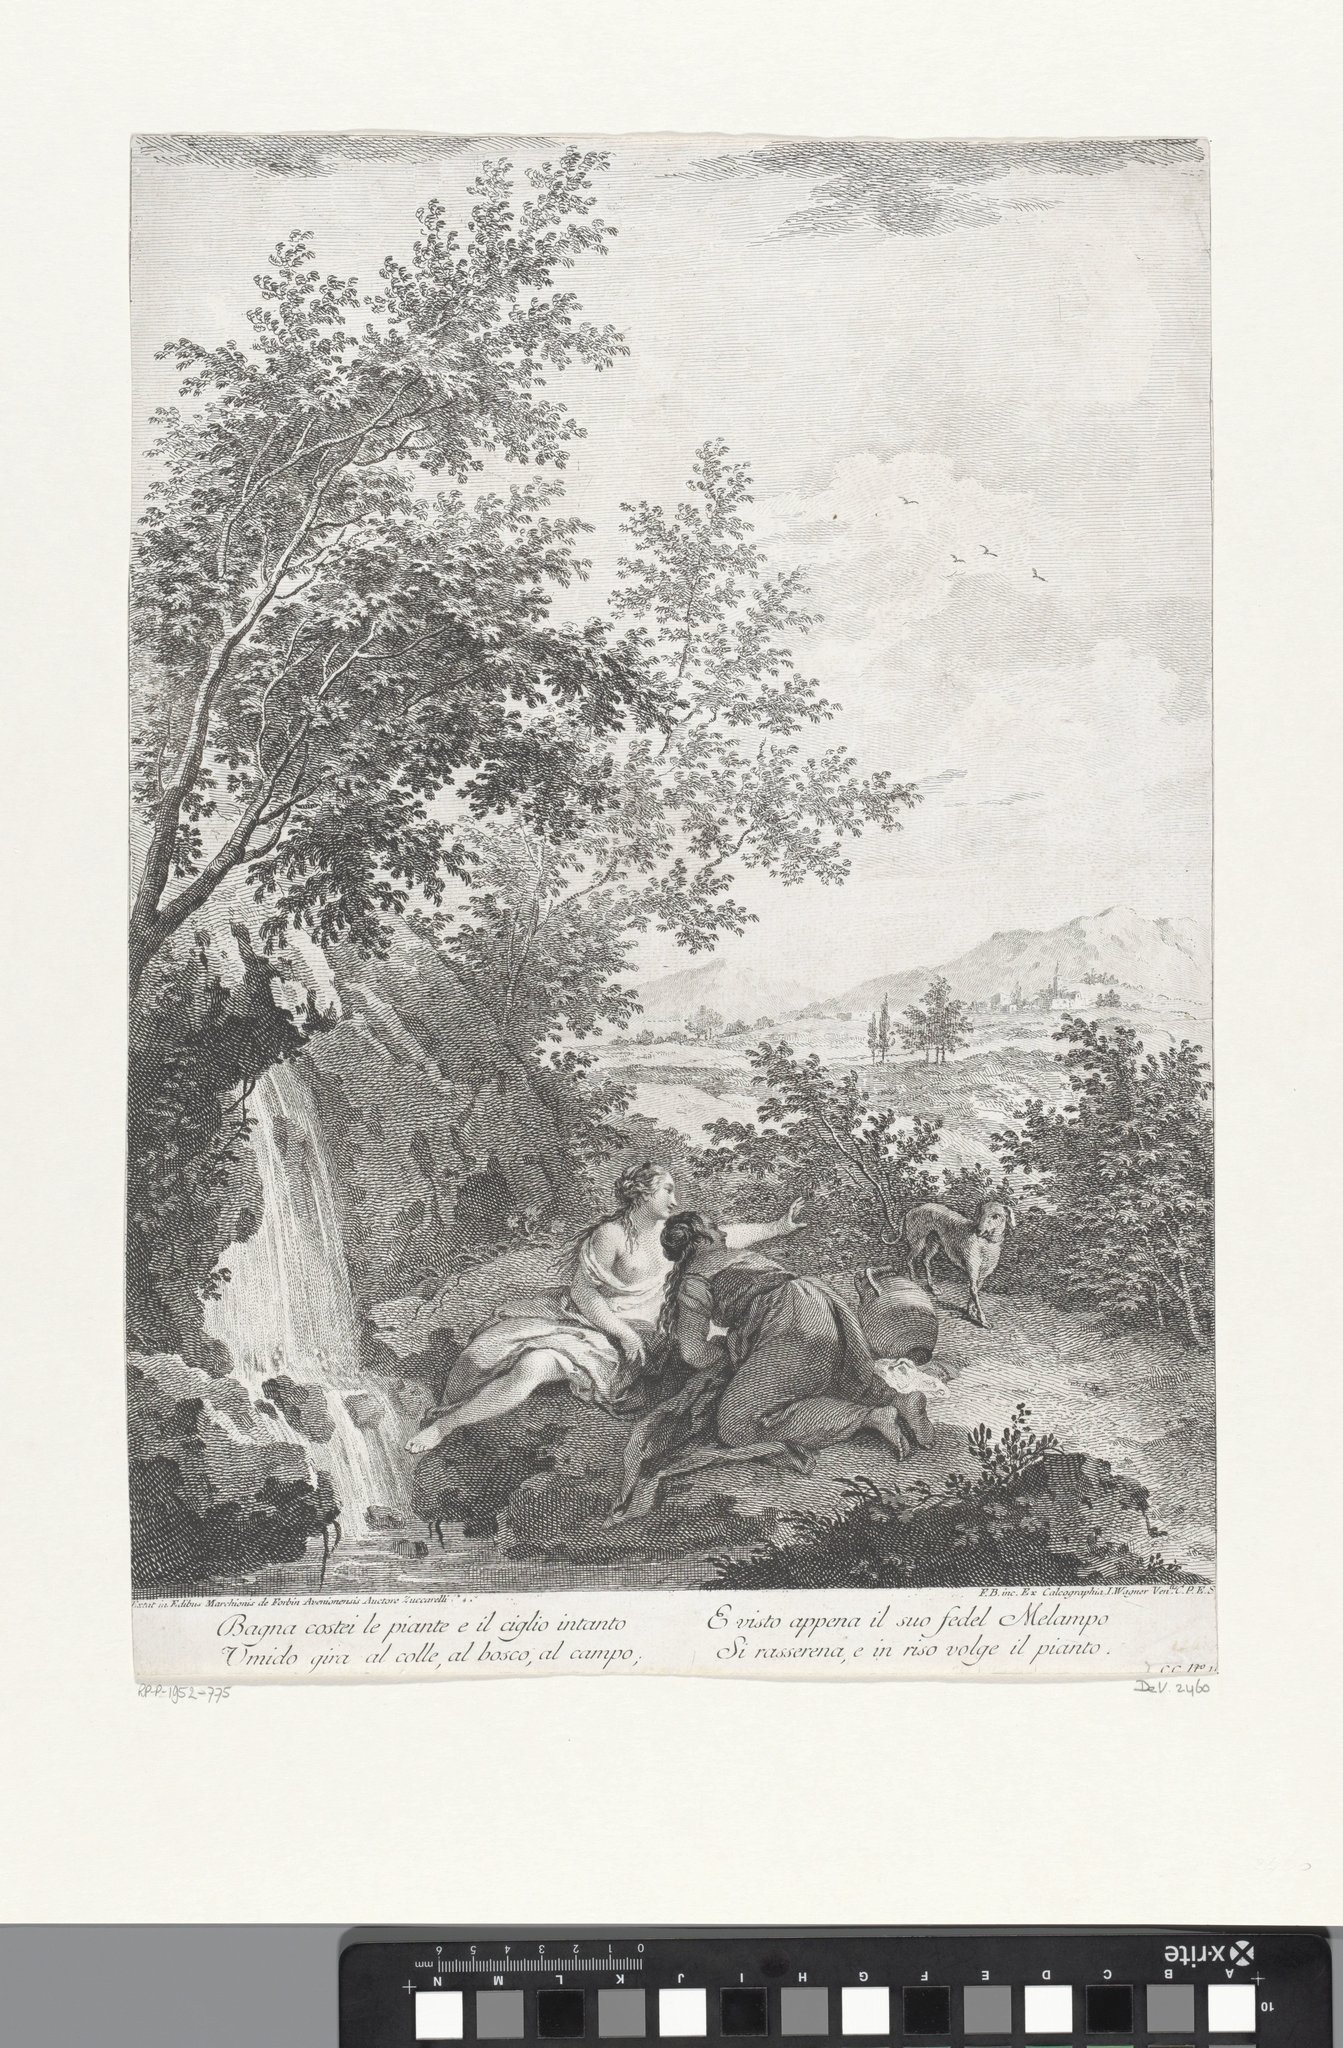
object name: print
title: Landschappen met boeren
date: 1739-1780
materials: paper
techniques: engraving, etching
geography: venice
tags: landscapes, waterfall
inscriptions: collector's mark: Lugt 2228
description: Landschap met twee vrouwen bij een waterval. De vrouwen draaien zich om naar een hond rechts. In ondermarge een vierregelig vers in het Italiaans. Genummerd rechtsonder: C.C. No. 1[?].